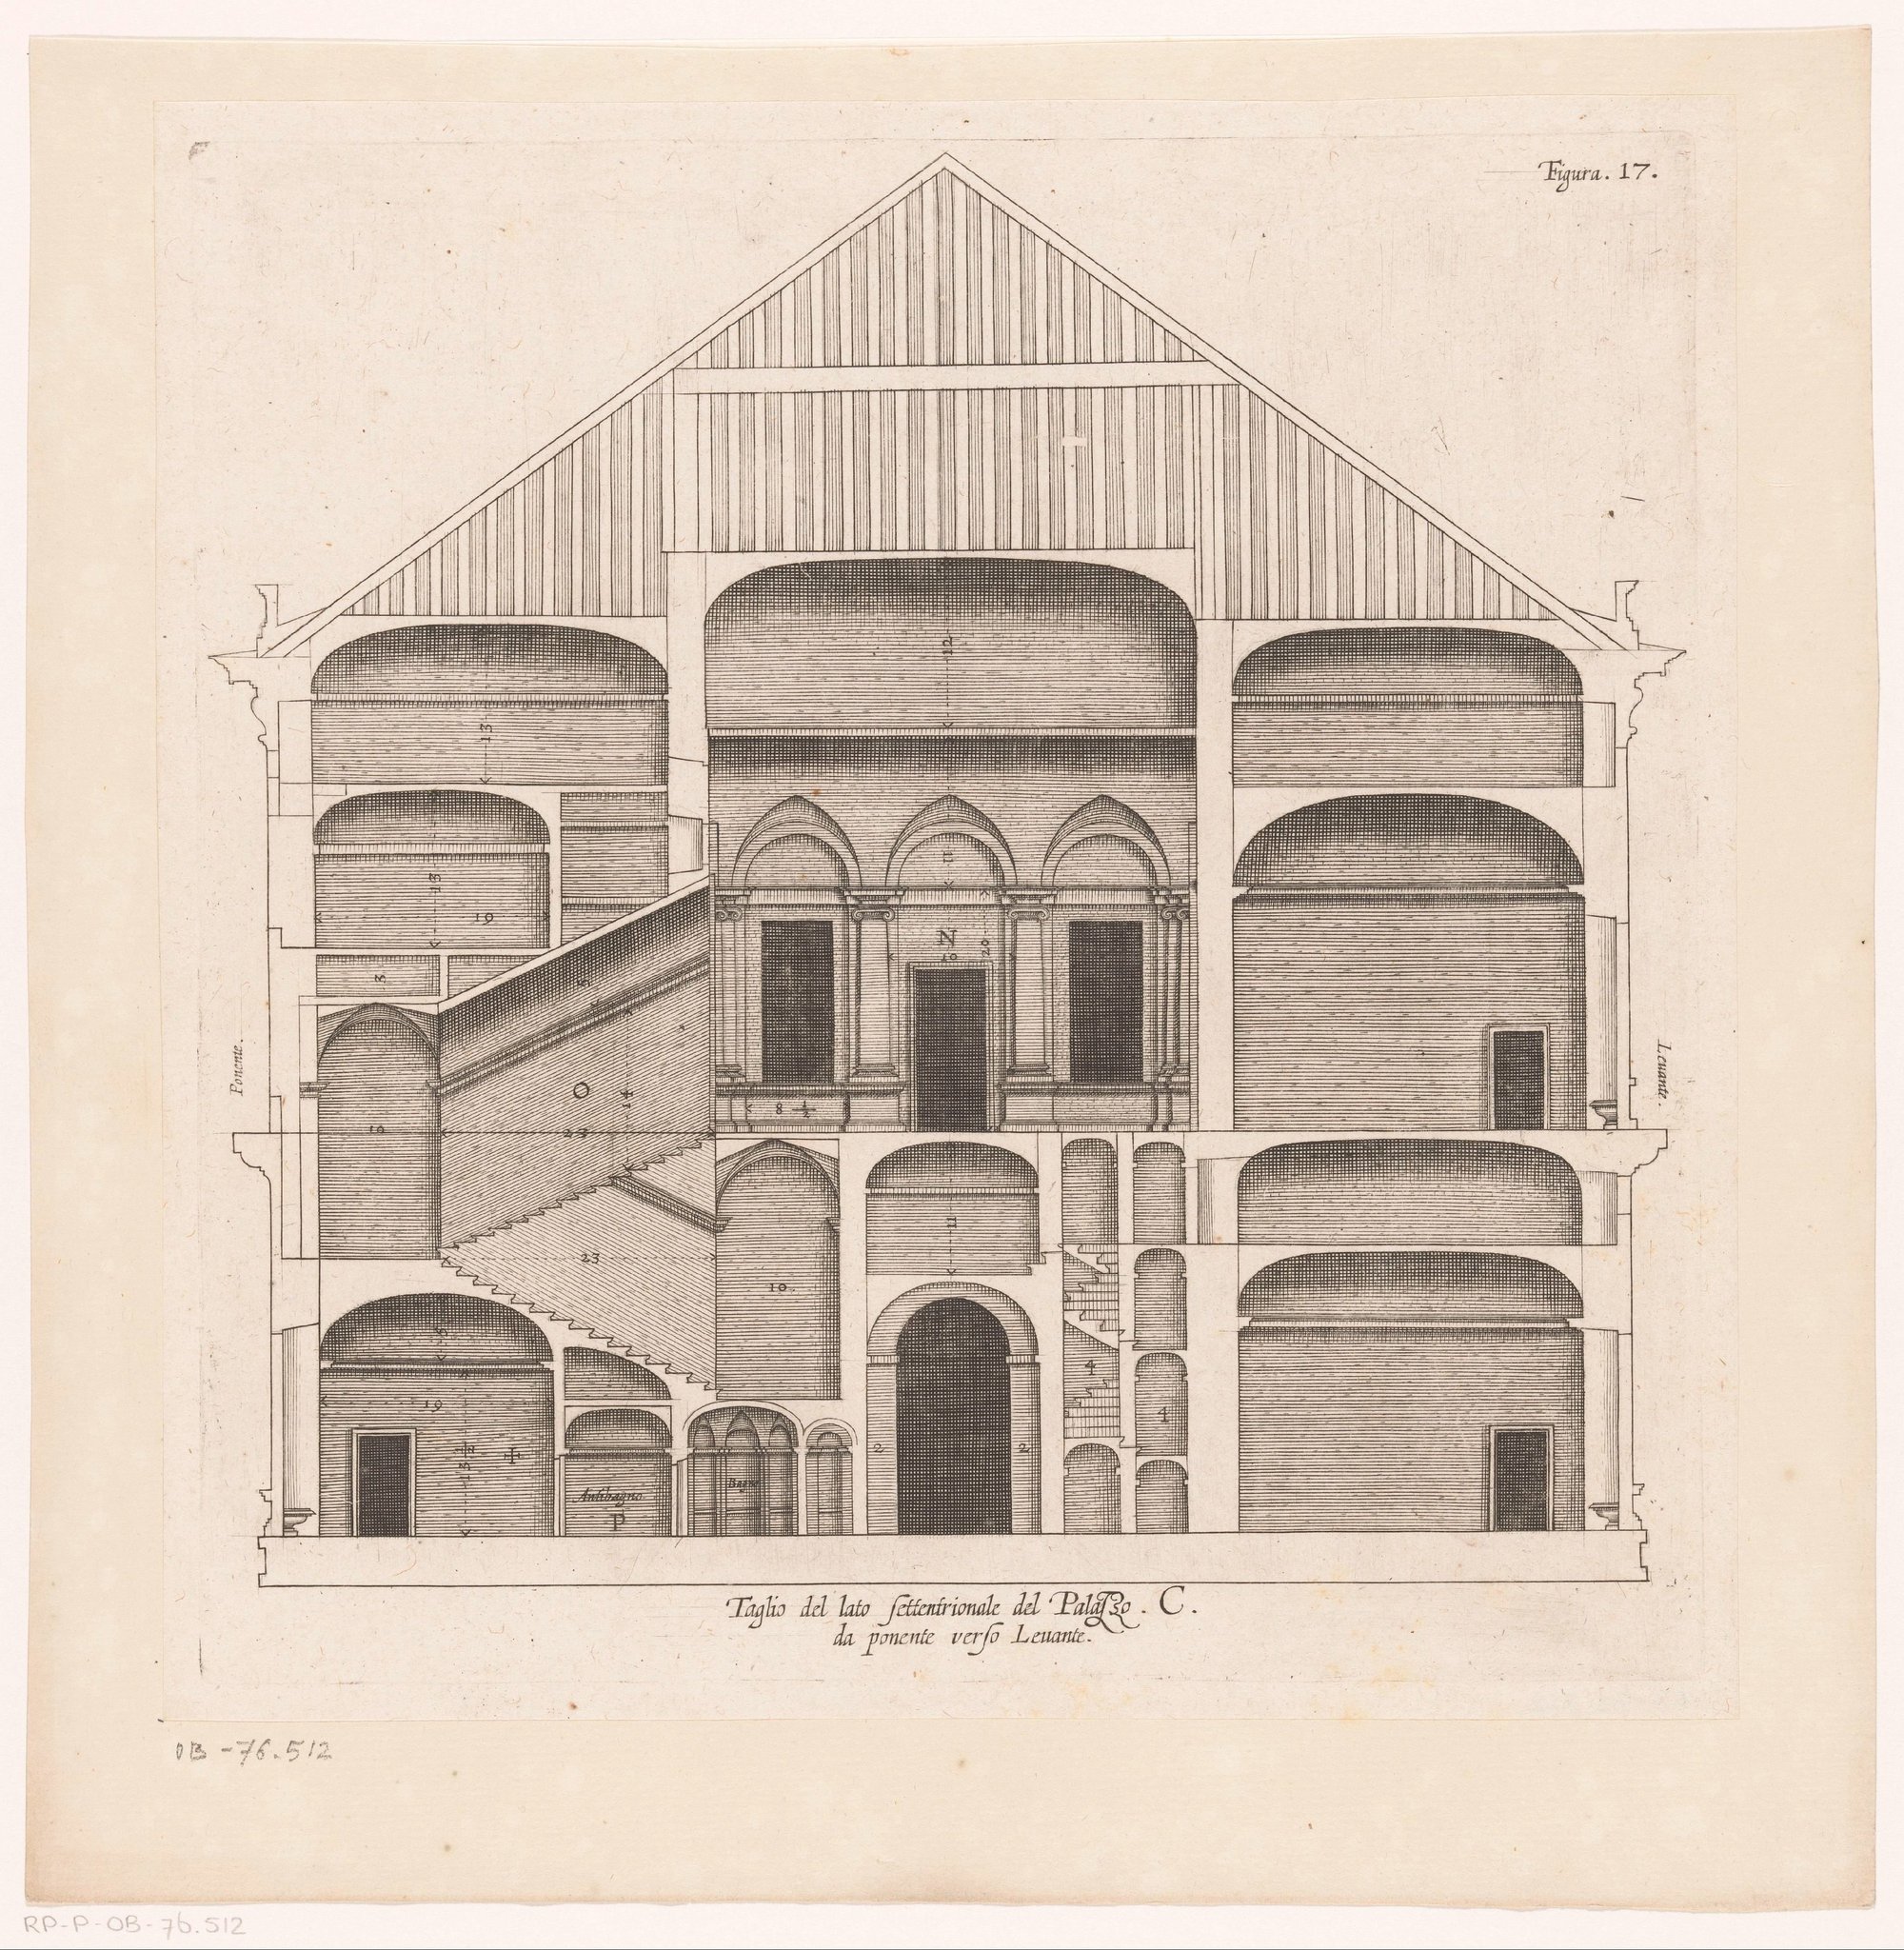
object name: print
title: Dwarsdoorsnede van de Villa Spinola di San Pietro te Genua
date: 1622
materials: paper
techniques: engraving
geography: antwerp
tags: hôtel, i.e. small palace in city - aa - civic architecture: inside, section ~ architectural design or model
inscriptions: collector's mark: Lugt 240